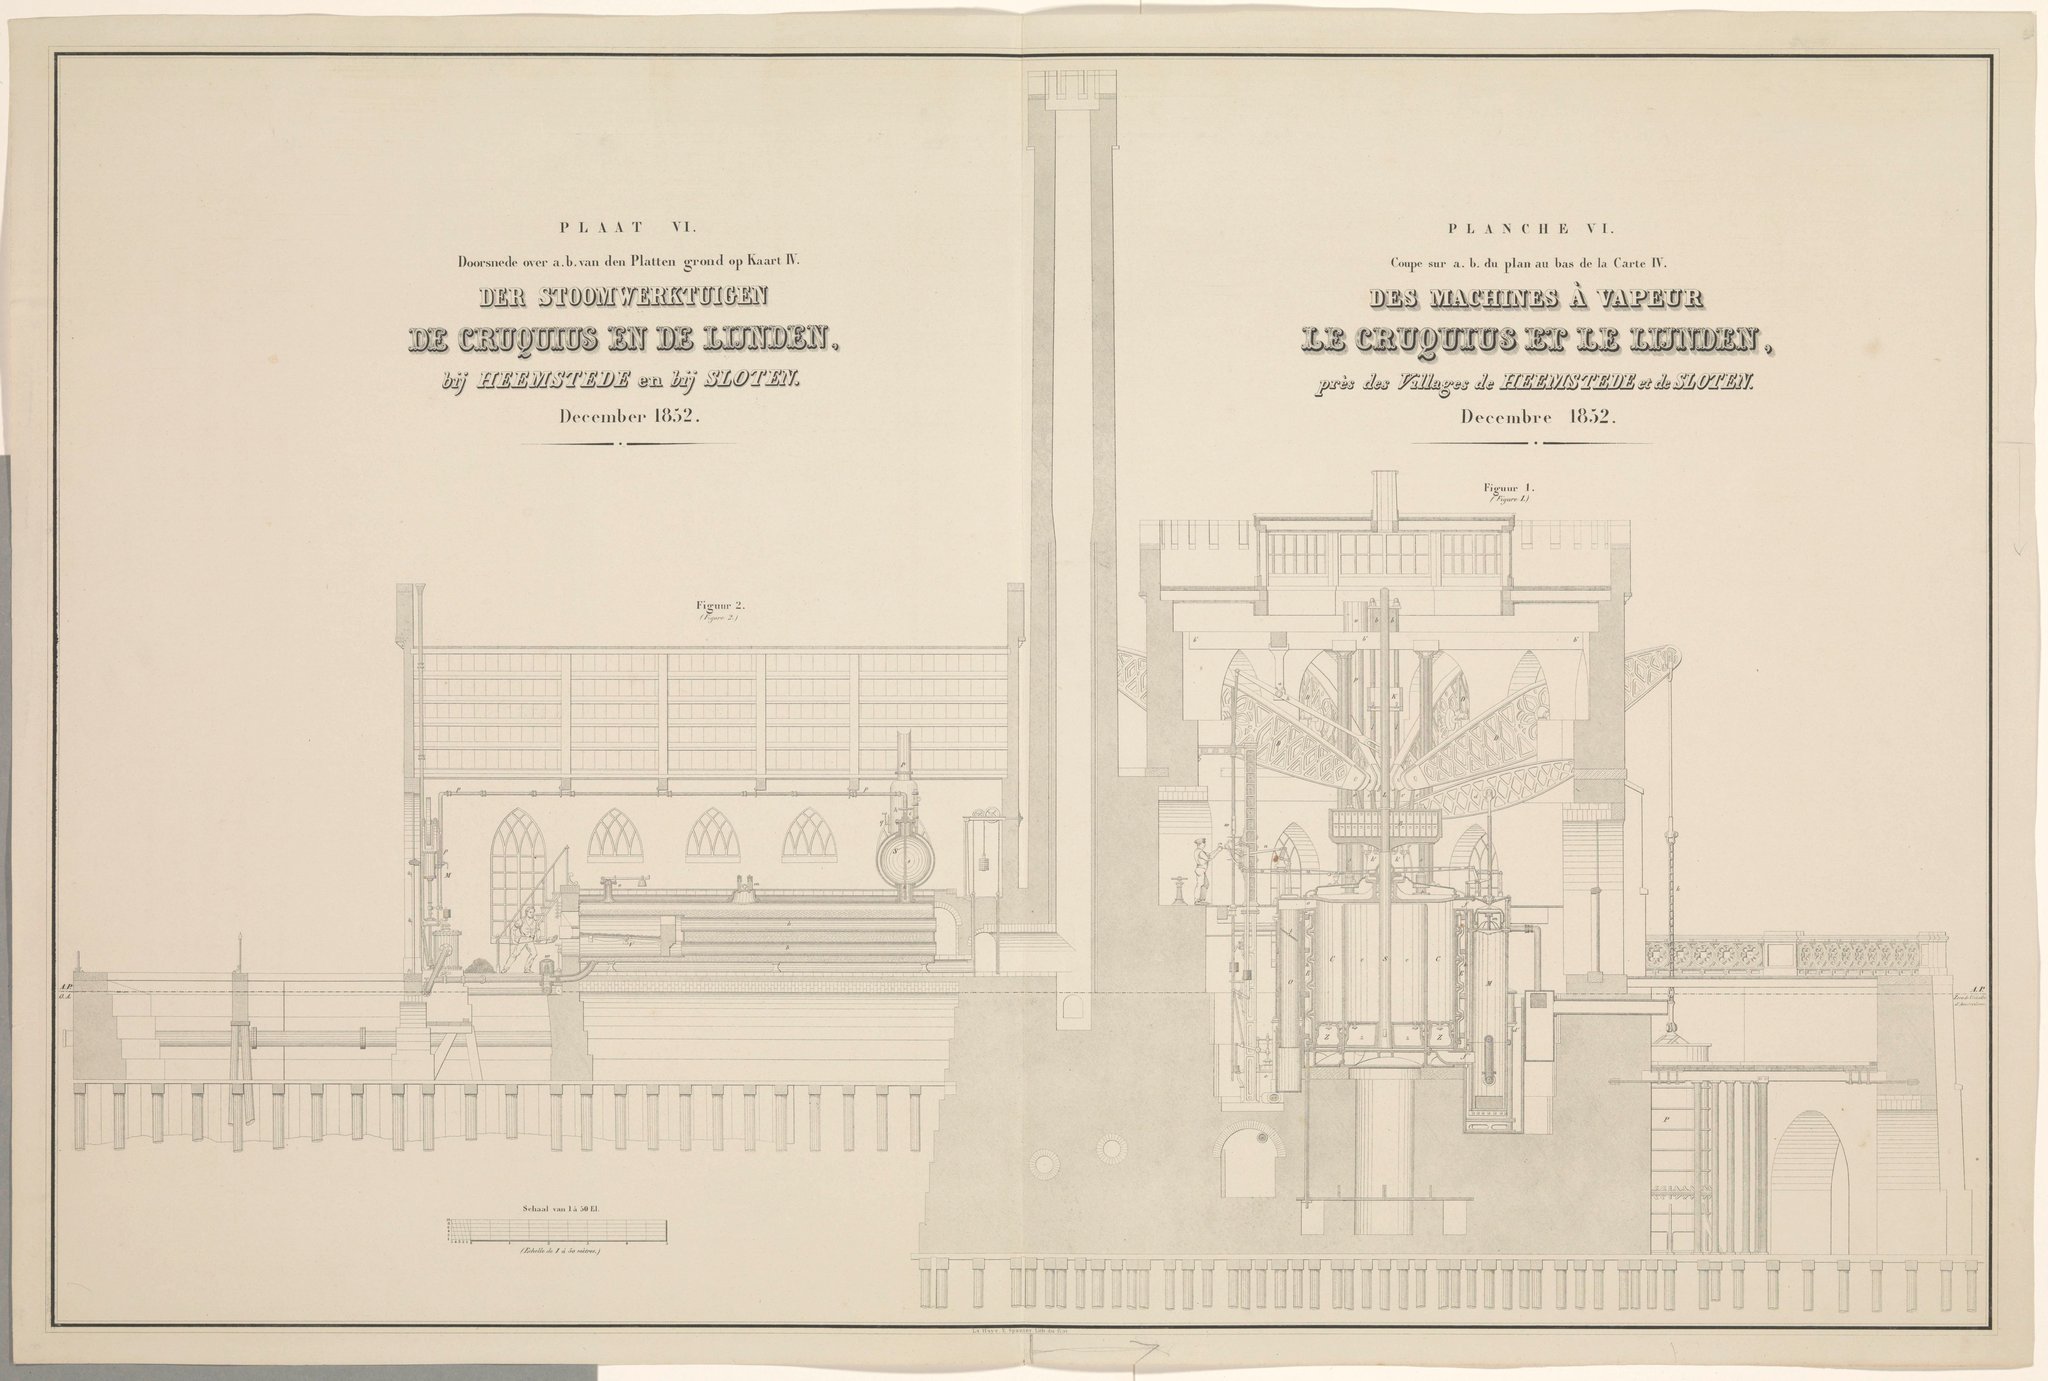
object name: print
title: Suite van tien kaarten en platen van de droogmaking van de Haarlemmermeer 1843-1860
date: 1852-1861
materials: paper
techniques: lithograph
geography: the hague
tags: maps of separate countries or regions, technical aspects and details of pumping-engine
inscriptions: collector's mark: Lugt 2228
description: Uitgegeven als illustratie in: Daniel Theodoor Gevers van Endegeest, Over de droogmaking van het Haarlemmermeer. 3 dln., Leiden : S. en J. Luchtmans. Uitg. later: 's Gravenhage : Gebroeders van Cleef, en: Amsterdam : Fred. Muller. 1843-1861.